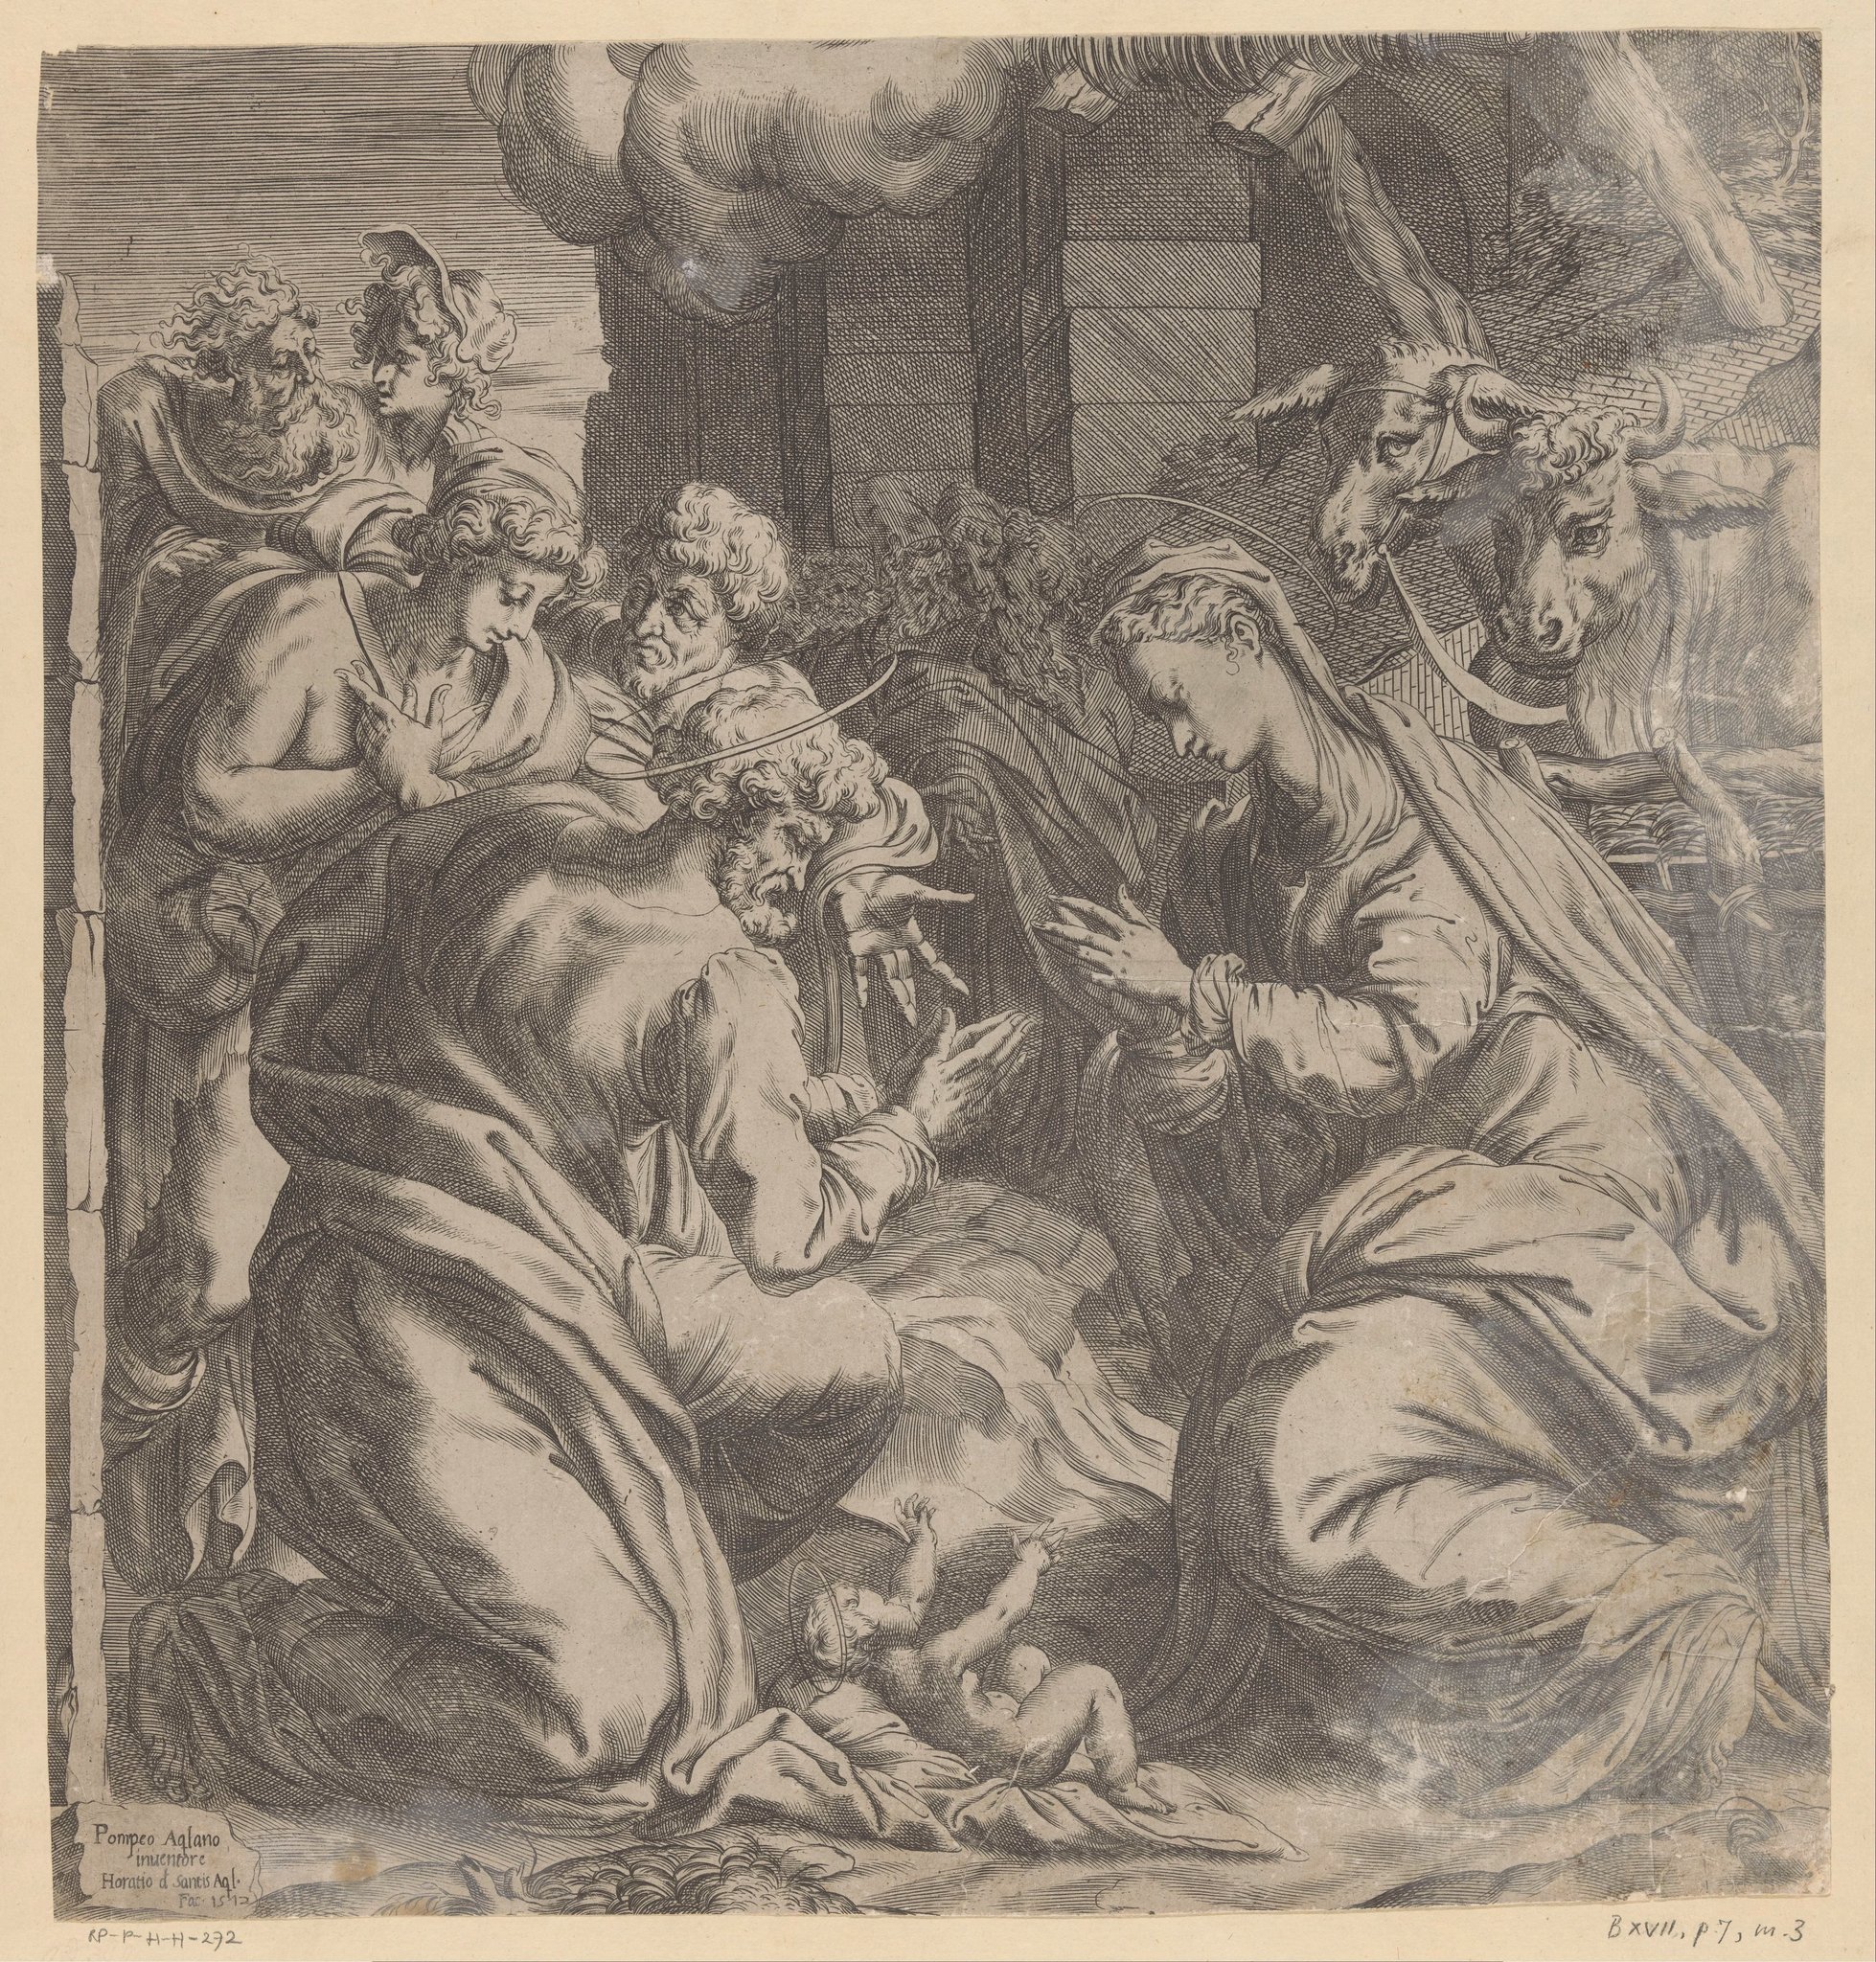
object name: print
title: Geboorte van Christus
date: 1572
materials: paper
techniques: engraving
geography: italy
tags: mary, joseph and the new-born christ (nativity)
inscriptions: collector's mark: ‘Hinloopen’, collector's mark: Lugt 11, collector's mark: Lugt 10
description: Maria en Jozef knielen bij de pasgeboren Christus. Op de achtergrond staan andere figuren die het Kind aanbidden. Rechts de os en de ezel.